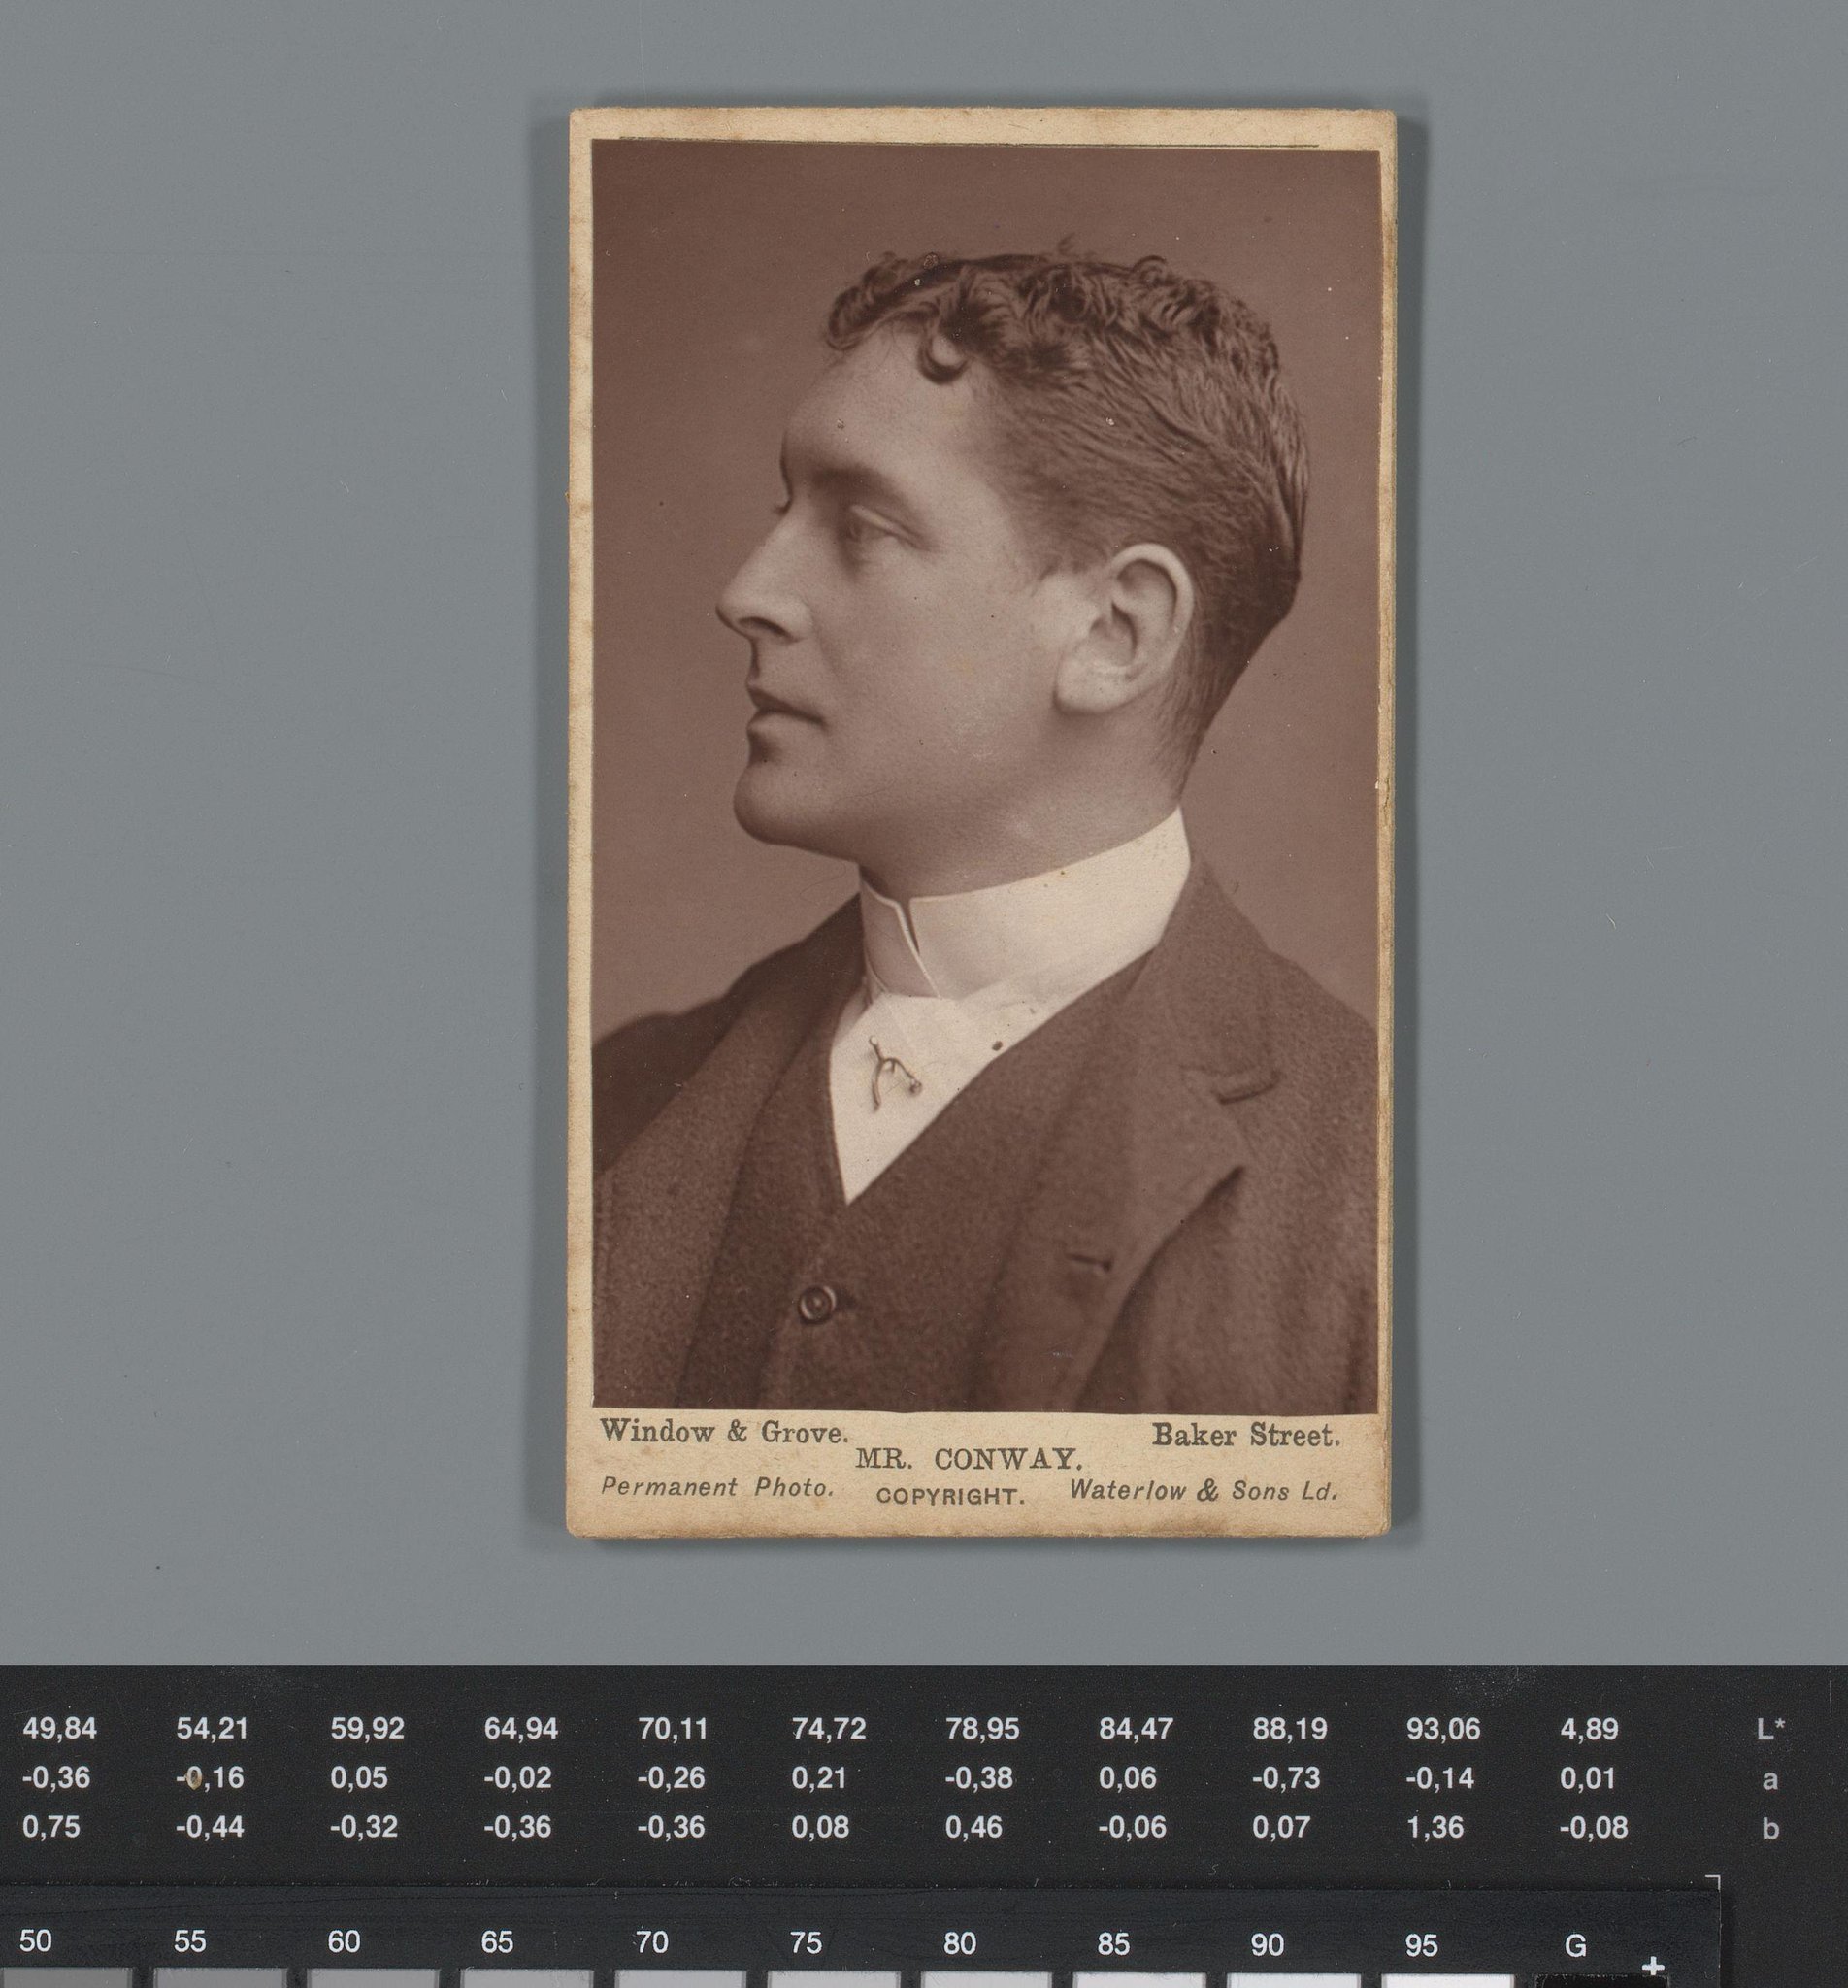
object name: photomechanical print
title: Reclame voor Taunus mineraalwater met een portret van Harry B. Conway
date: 1865-1900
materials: cardboard, photographic support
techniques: woodburytype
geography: london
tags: advertising, historical persons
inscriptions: inscription: ‘"TAUNUS," / THE ROYAL TABLE WATER (...)’